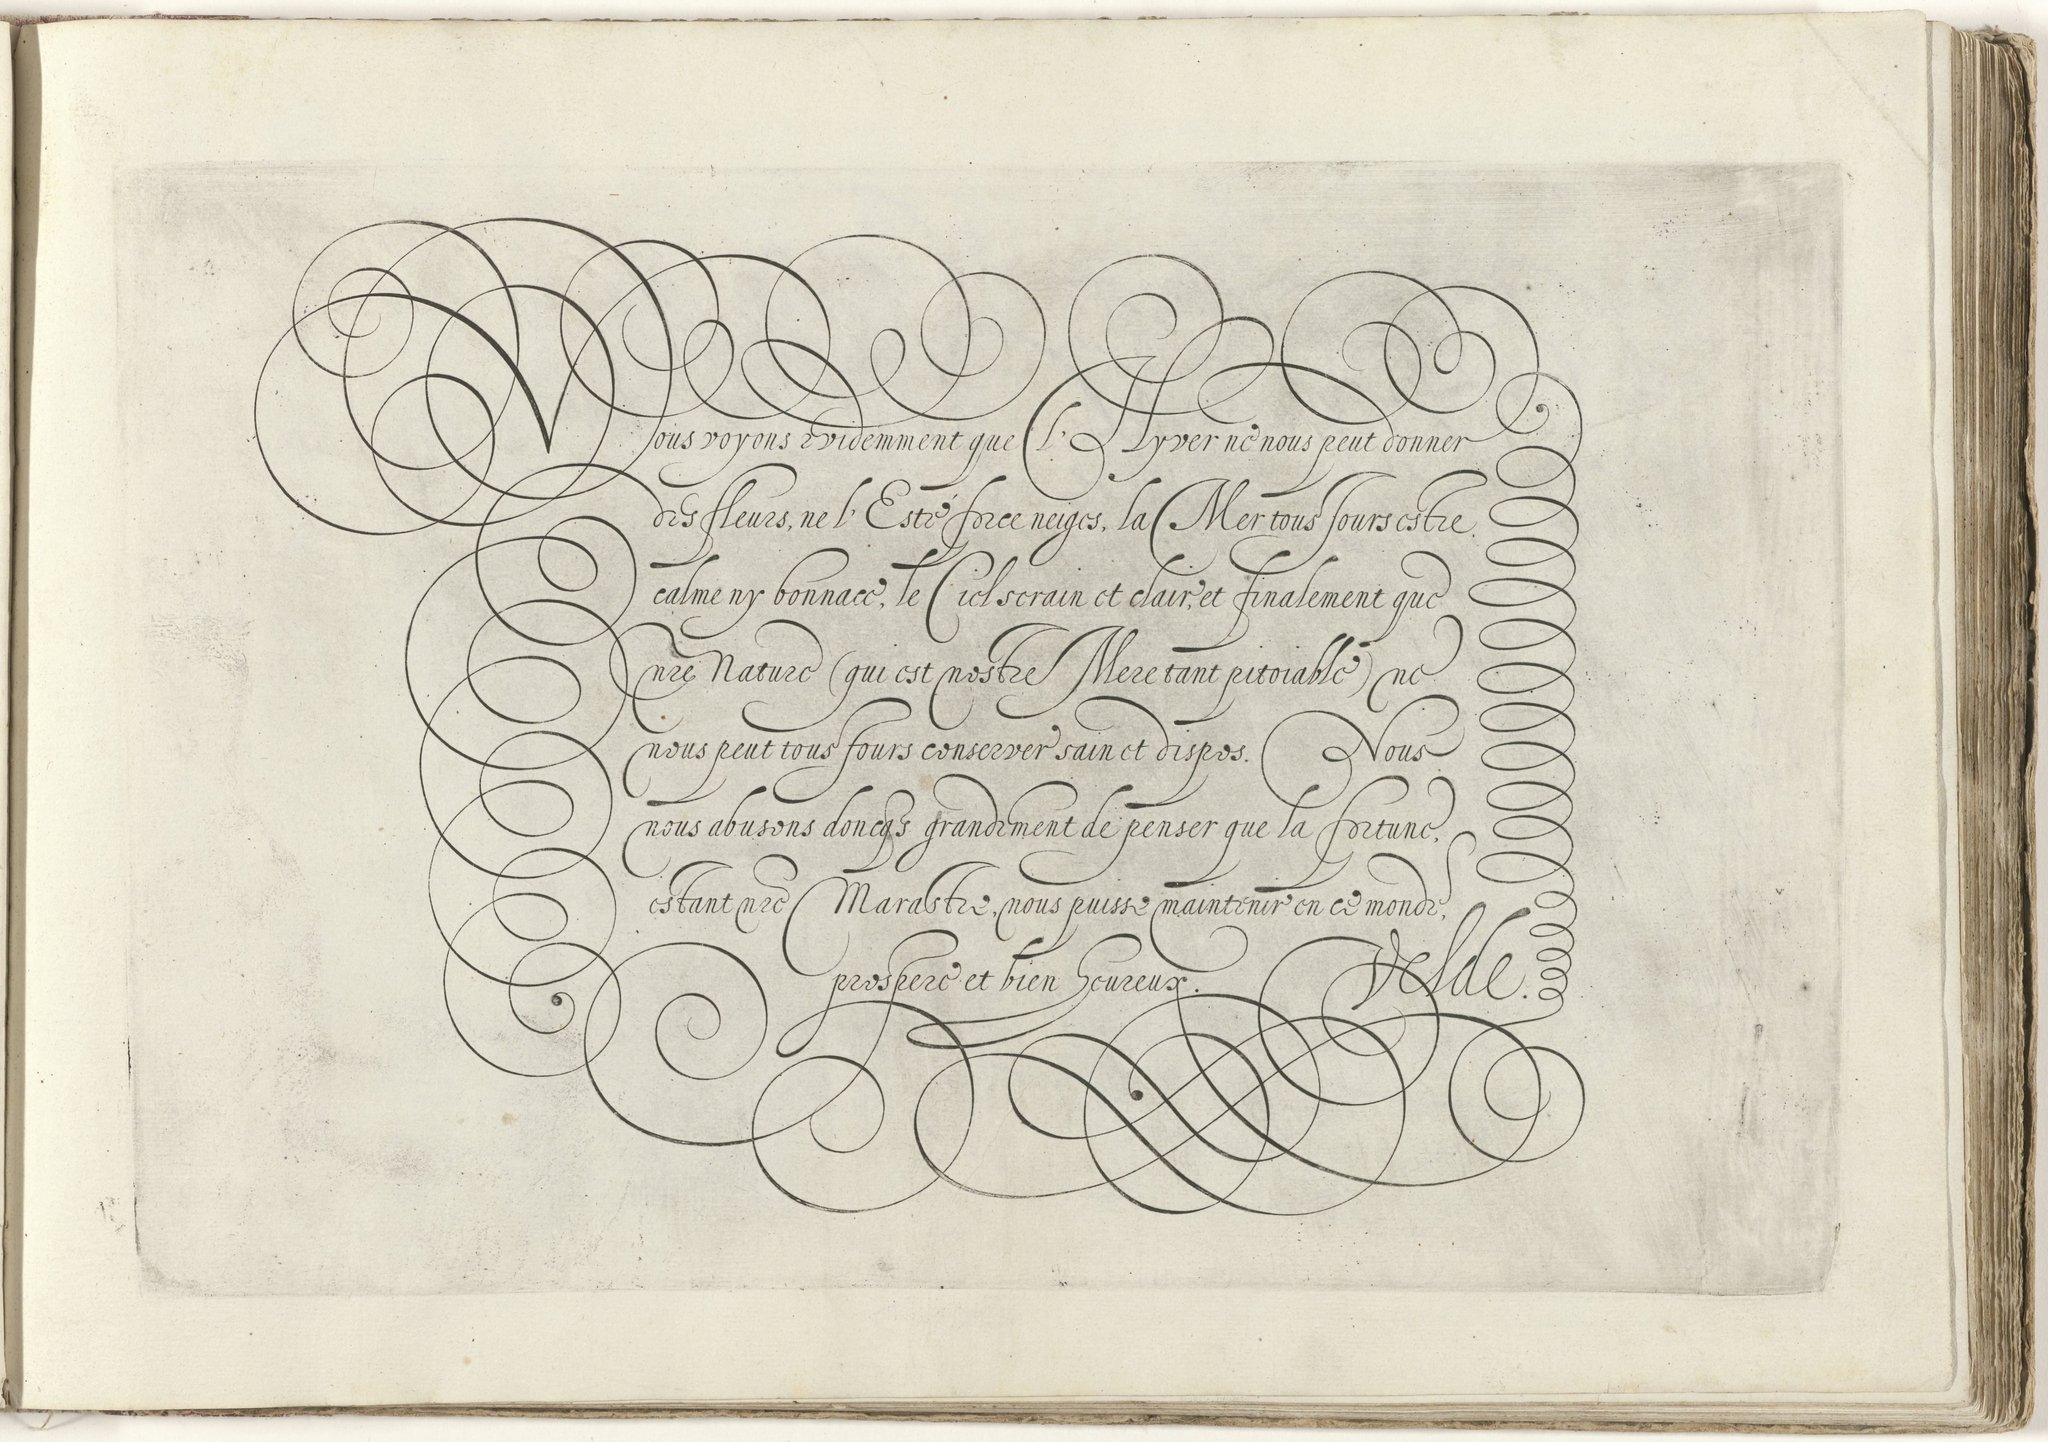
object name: print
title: Schrijfvoorbeeld: Nous voyons evidemment (...)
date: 1605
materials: paper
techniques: engraving, intaglio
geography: amsterdam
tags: calligraphy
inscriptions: collector's mark: Lugt 2760, collector's mark: Lugt 2228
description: Schrijfvoorbeeld met acht regels tekst in het Frans: Nous voyons evidemment ... De tekst is omlijst met krulwerk. De prent maakt deel uit van een album.